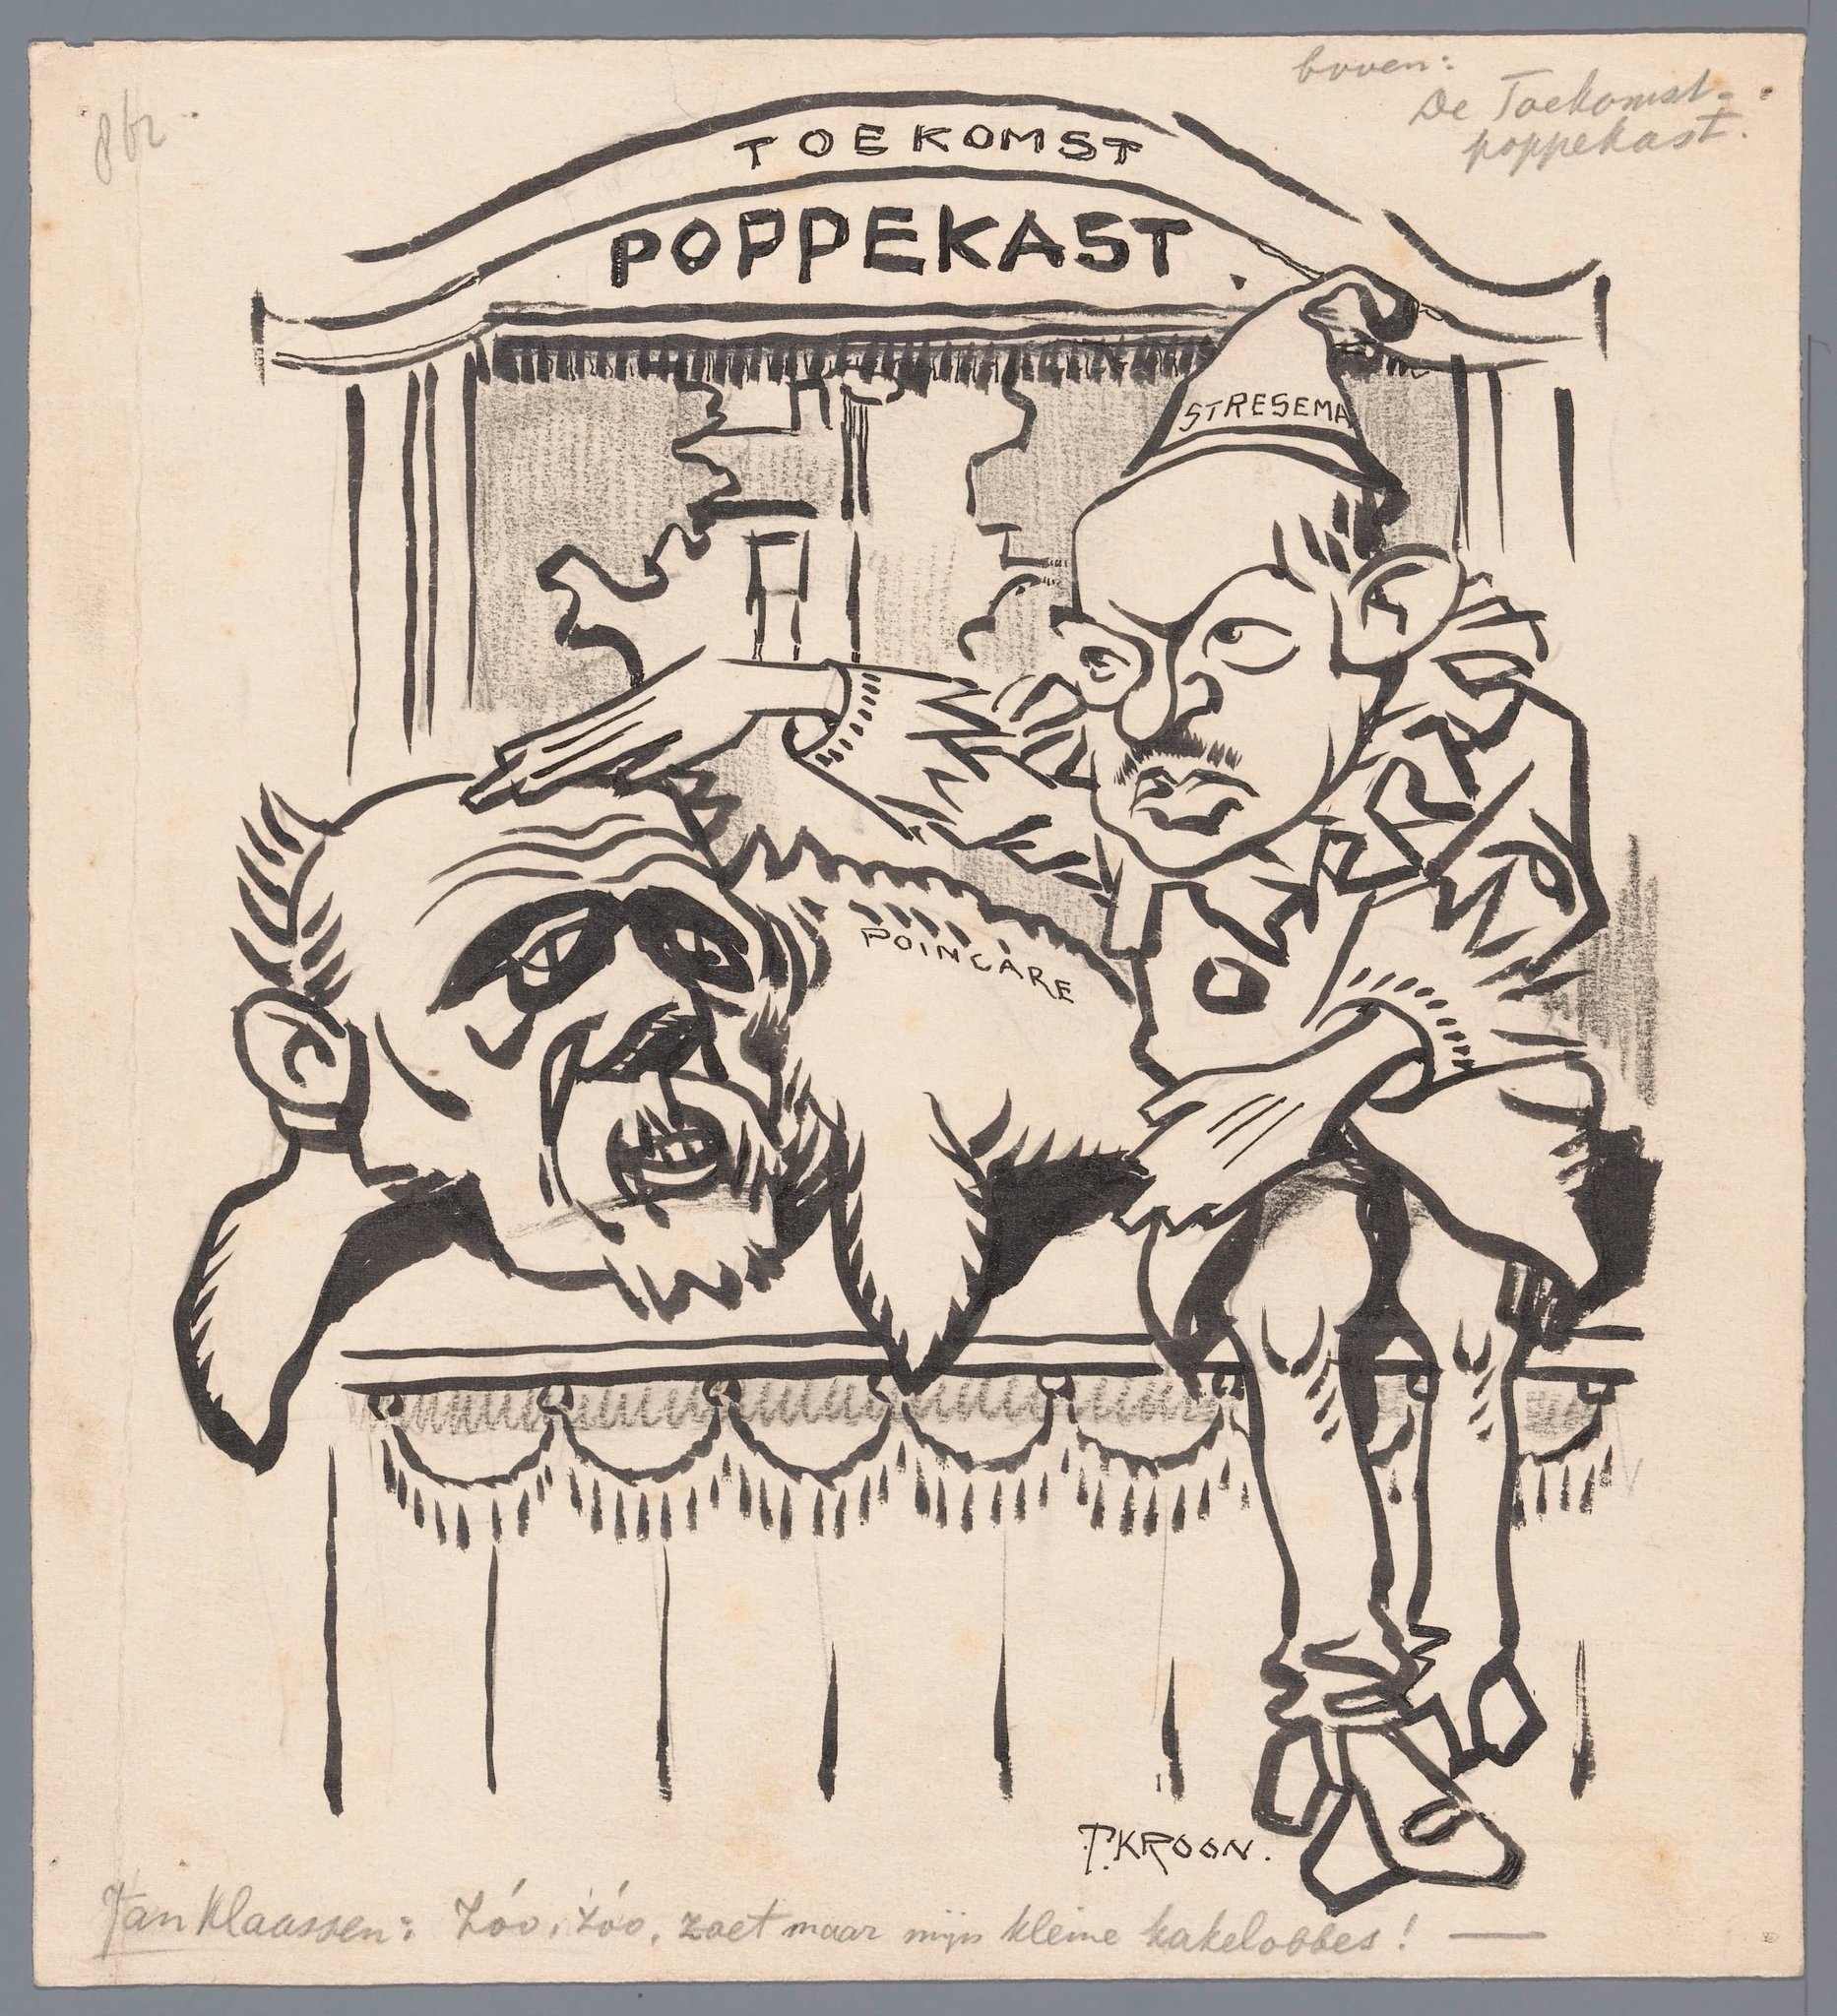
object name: cartoon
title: De Toekomst Poppekast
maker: patricq kroon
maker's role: draughtsman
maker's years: 1862-1941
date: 1920-1925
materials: paper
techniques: pen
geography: netherlands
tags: berlin, puppet and marionette show, political caricatures and satires, germany, france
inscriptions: number: ‘13019’, inscription: ‘De Toekomst poppekast’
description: Poppenkast met de Duitse minister Gustav Stresemann en de Franse premier Raymond Poincaré, ca. 1920-1925. Ontwerp voor een politieke spotprent.